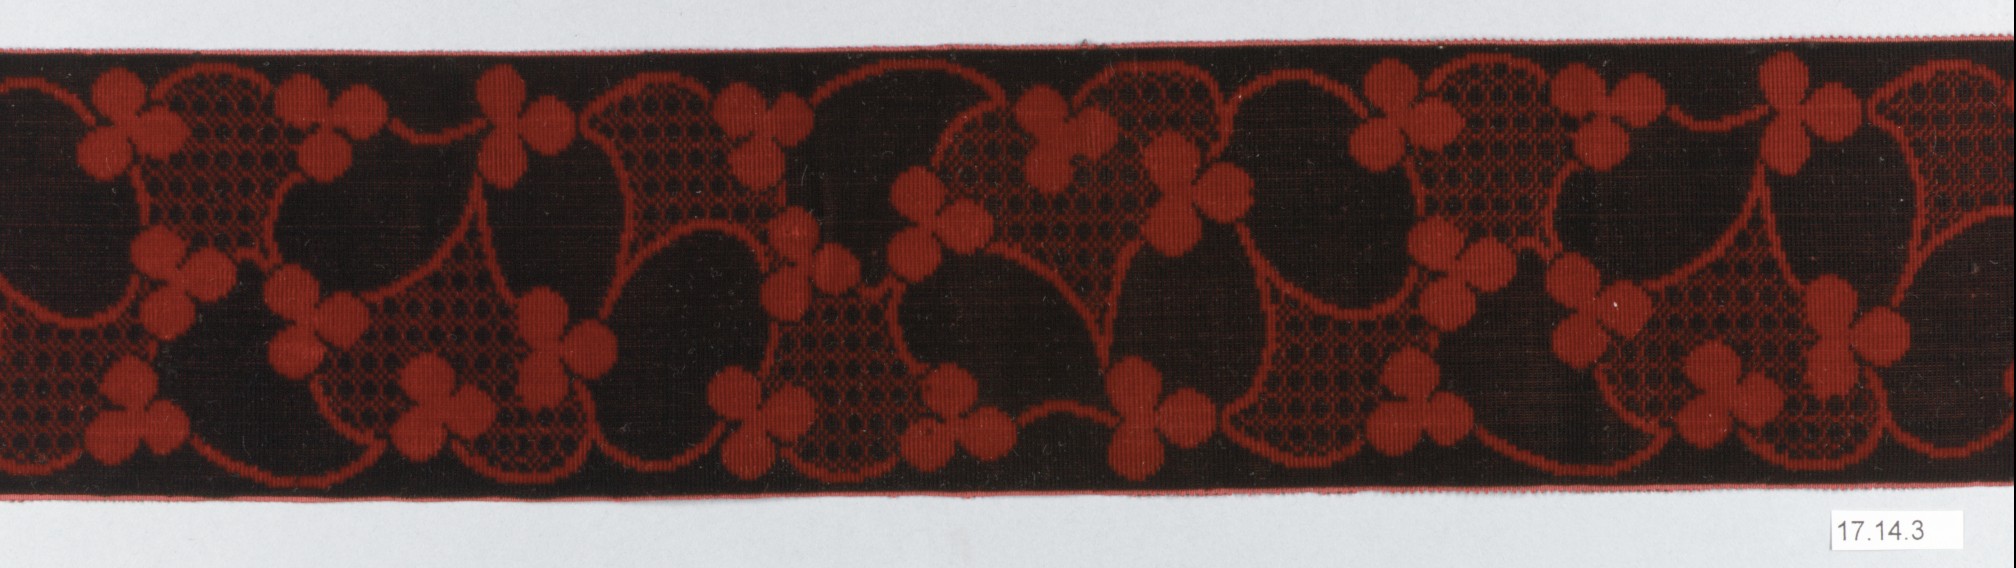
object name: ribbon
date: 1701-1800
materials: velvet